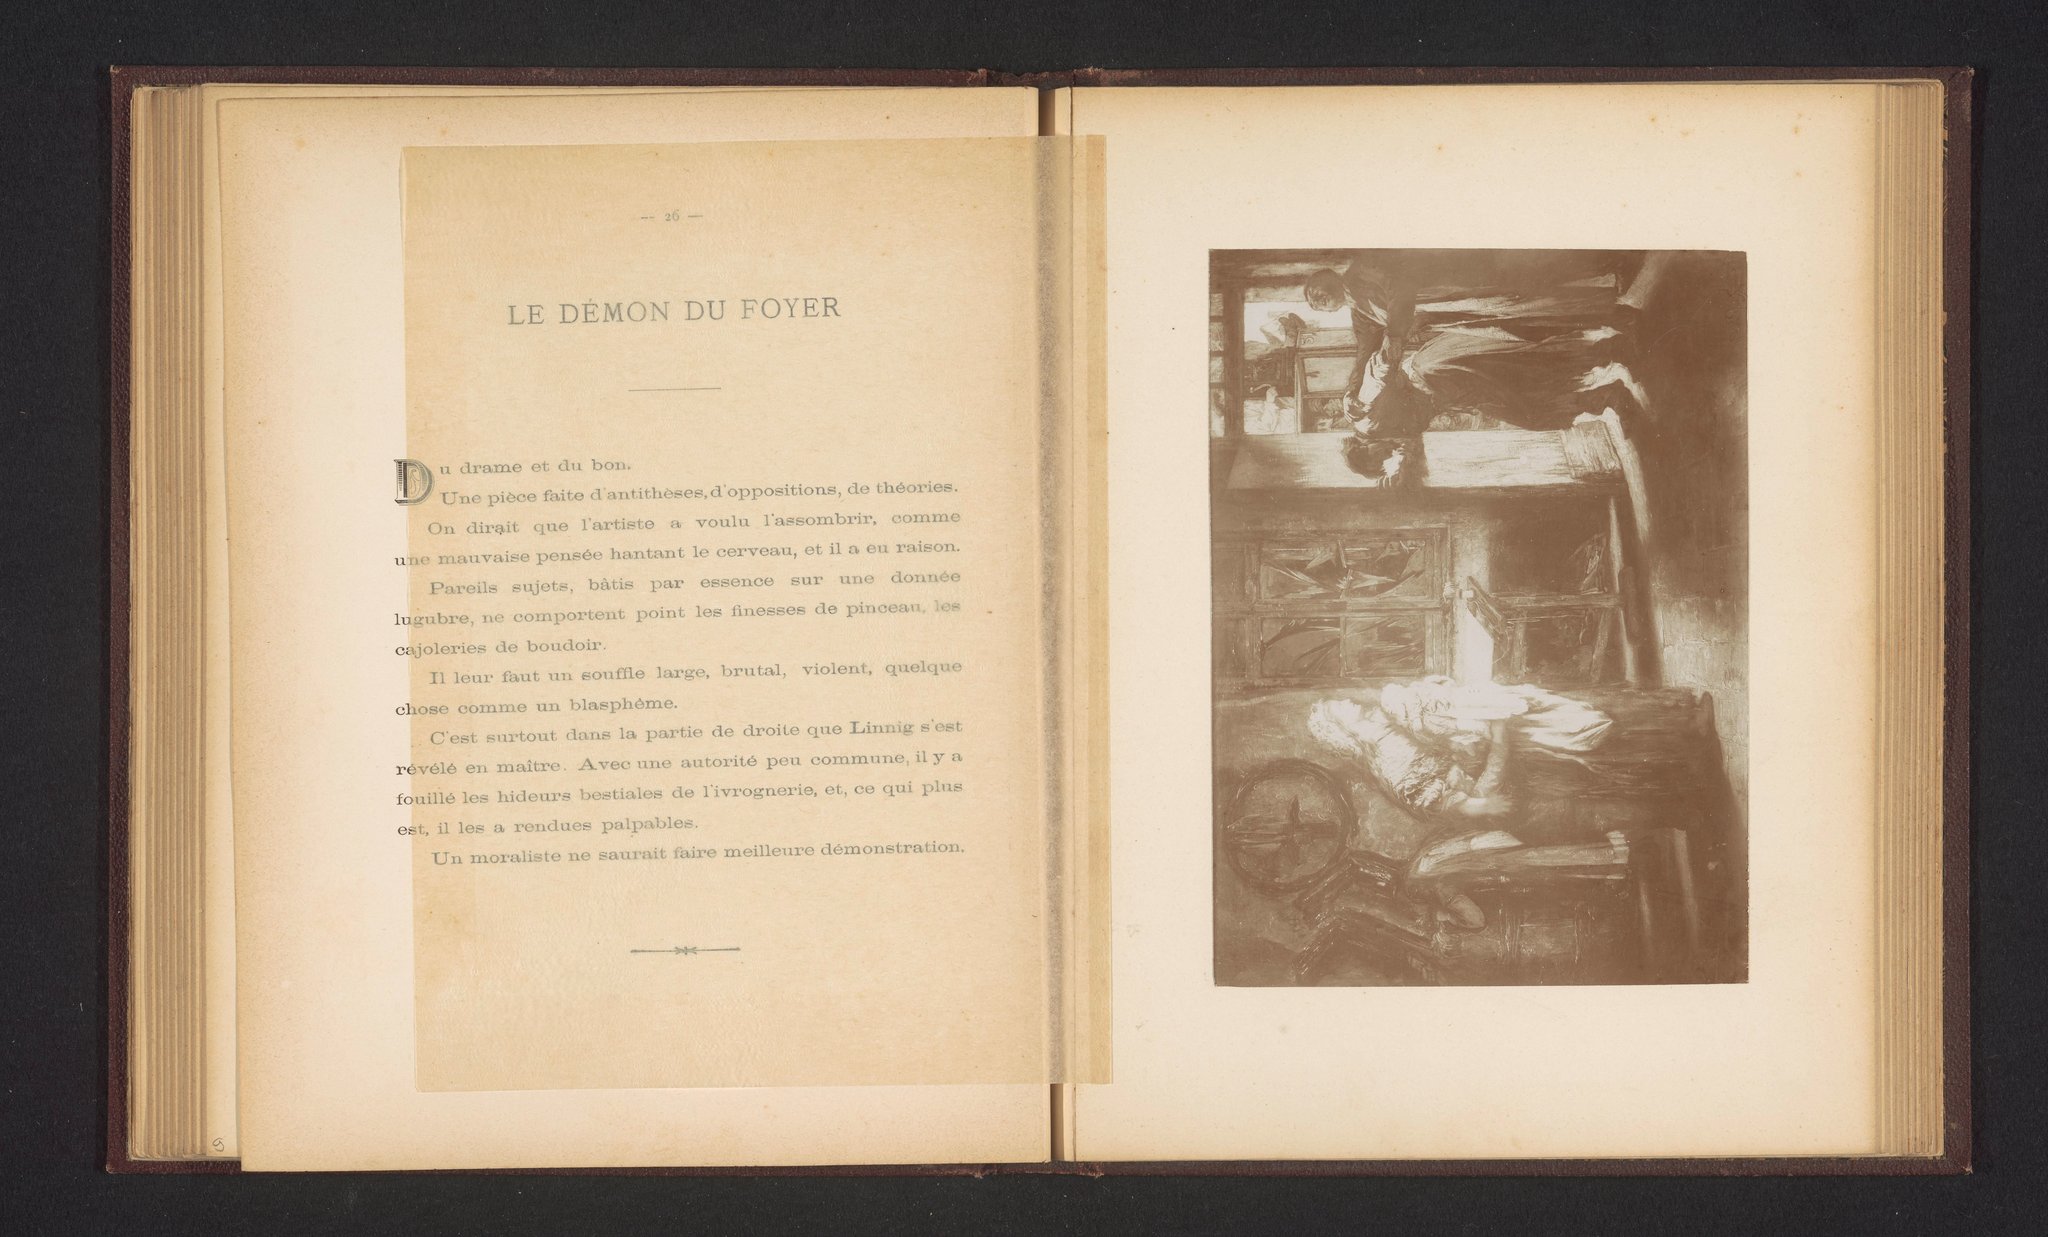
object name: page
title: Fotoreproductie van een schilderij van het goed en het kwaad in een voorkamer door Willem Linnig (II)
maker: alexandre van antro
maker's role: painter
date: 1891-1896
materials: photographic support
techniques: collodion silver print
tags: good, right, bad, evil, wrong, vestibule, hall